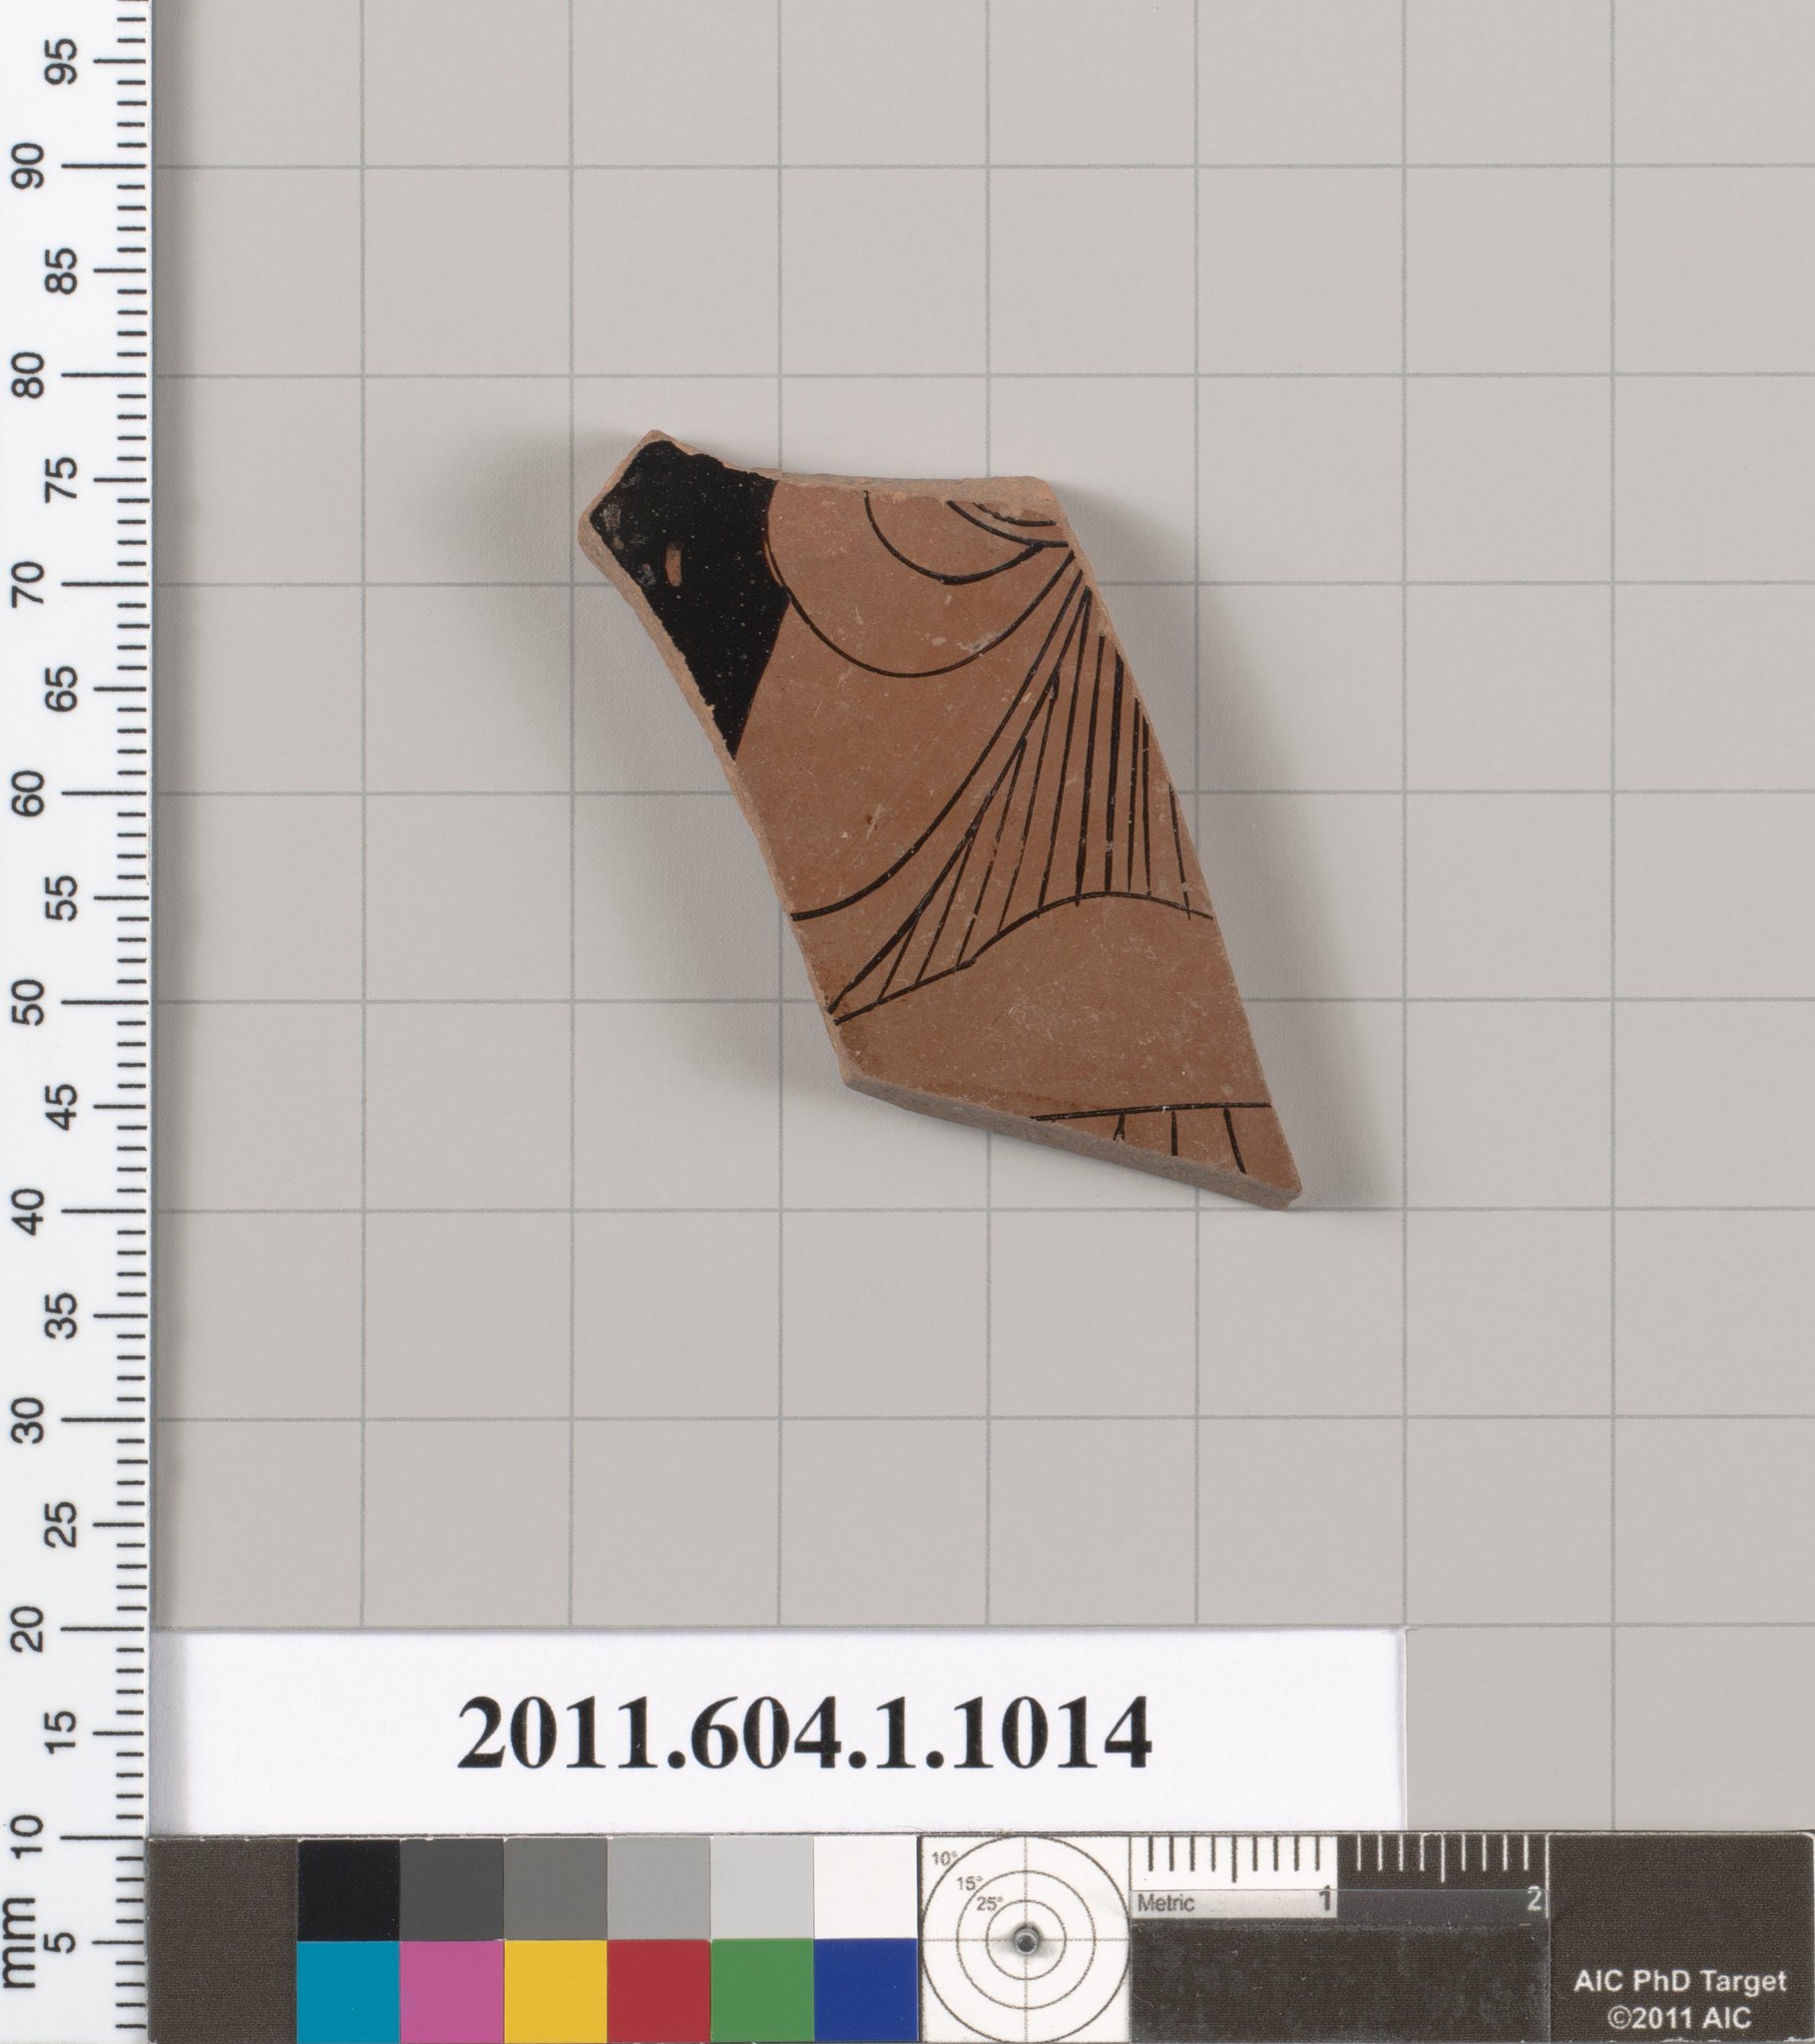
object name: kylix fragment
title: Terracotta fragment of a kylix (drinking cup)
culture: greek, attic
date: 500-476 BCE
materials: terracotta